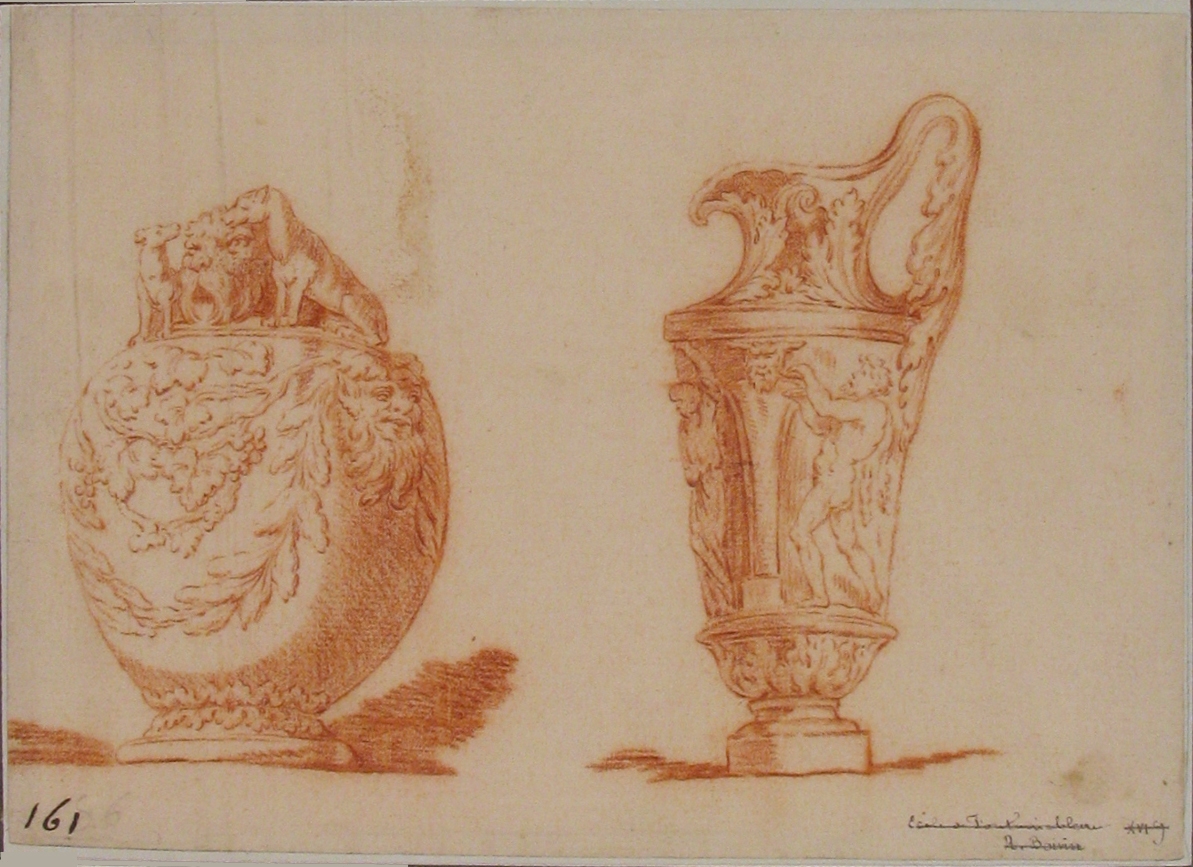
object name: drawing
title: Designs for Two Vases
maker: anonymous, french, 18th century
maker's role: artist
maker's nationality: french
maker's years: 1700-1800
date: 1701-1800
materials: chalk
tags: animals,male nudes,vases